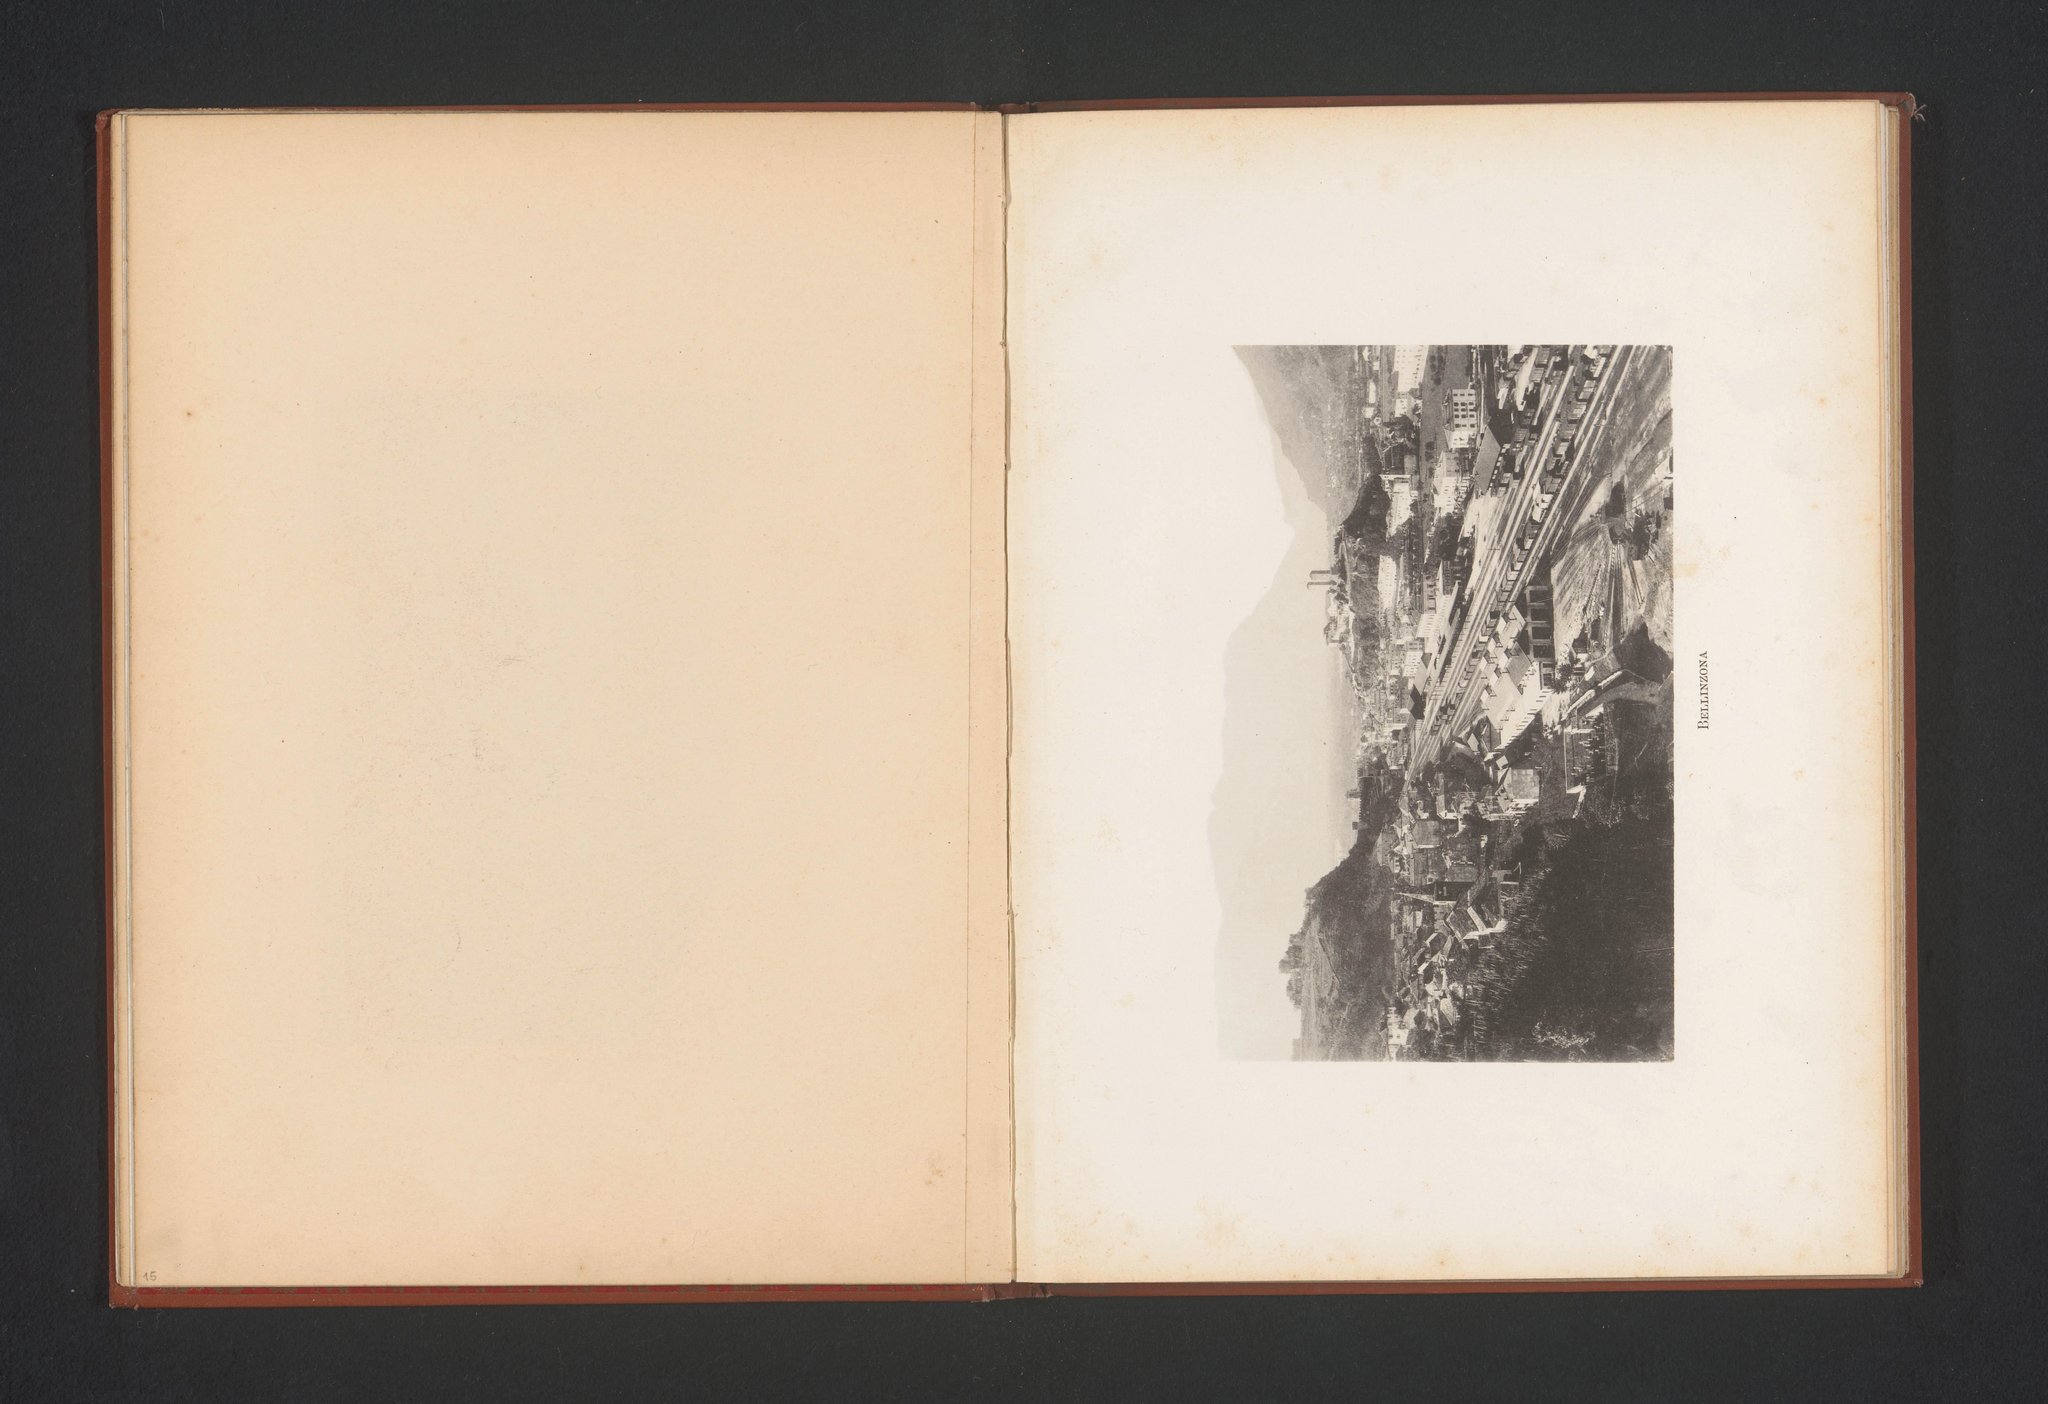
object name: page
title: Bellinzona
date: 1893-1898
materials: paper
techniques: photograph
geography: bellinzona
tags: city-view in general; 'veduta', mountains